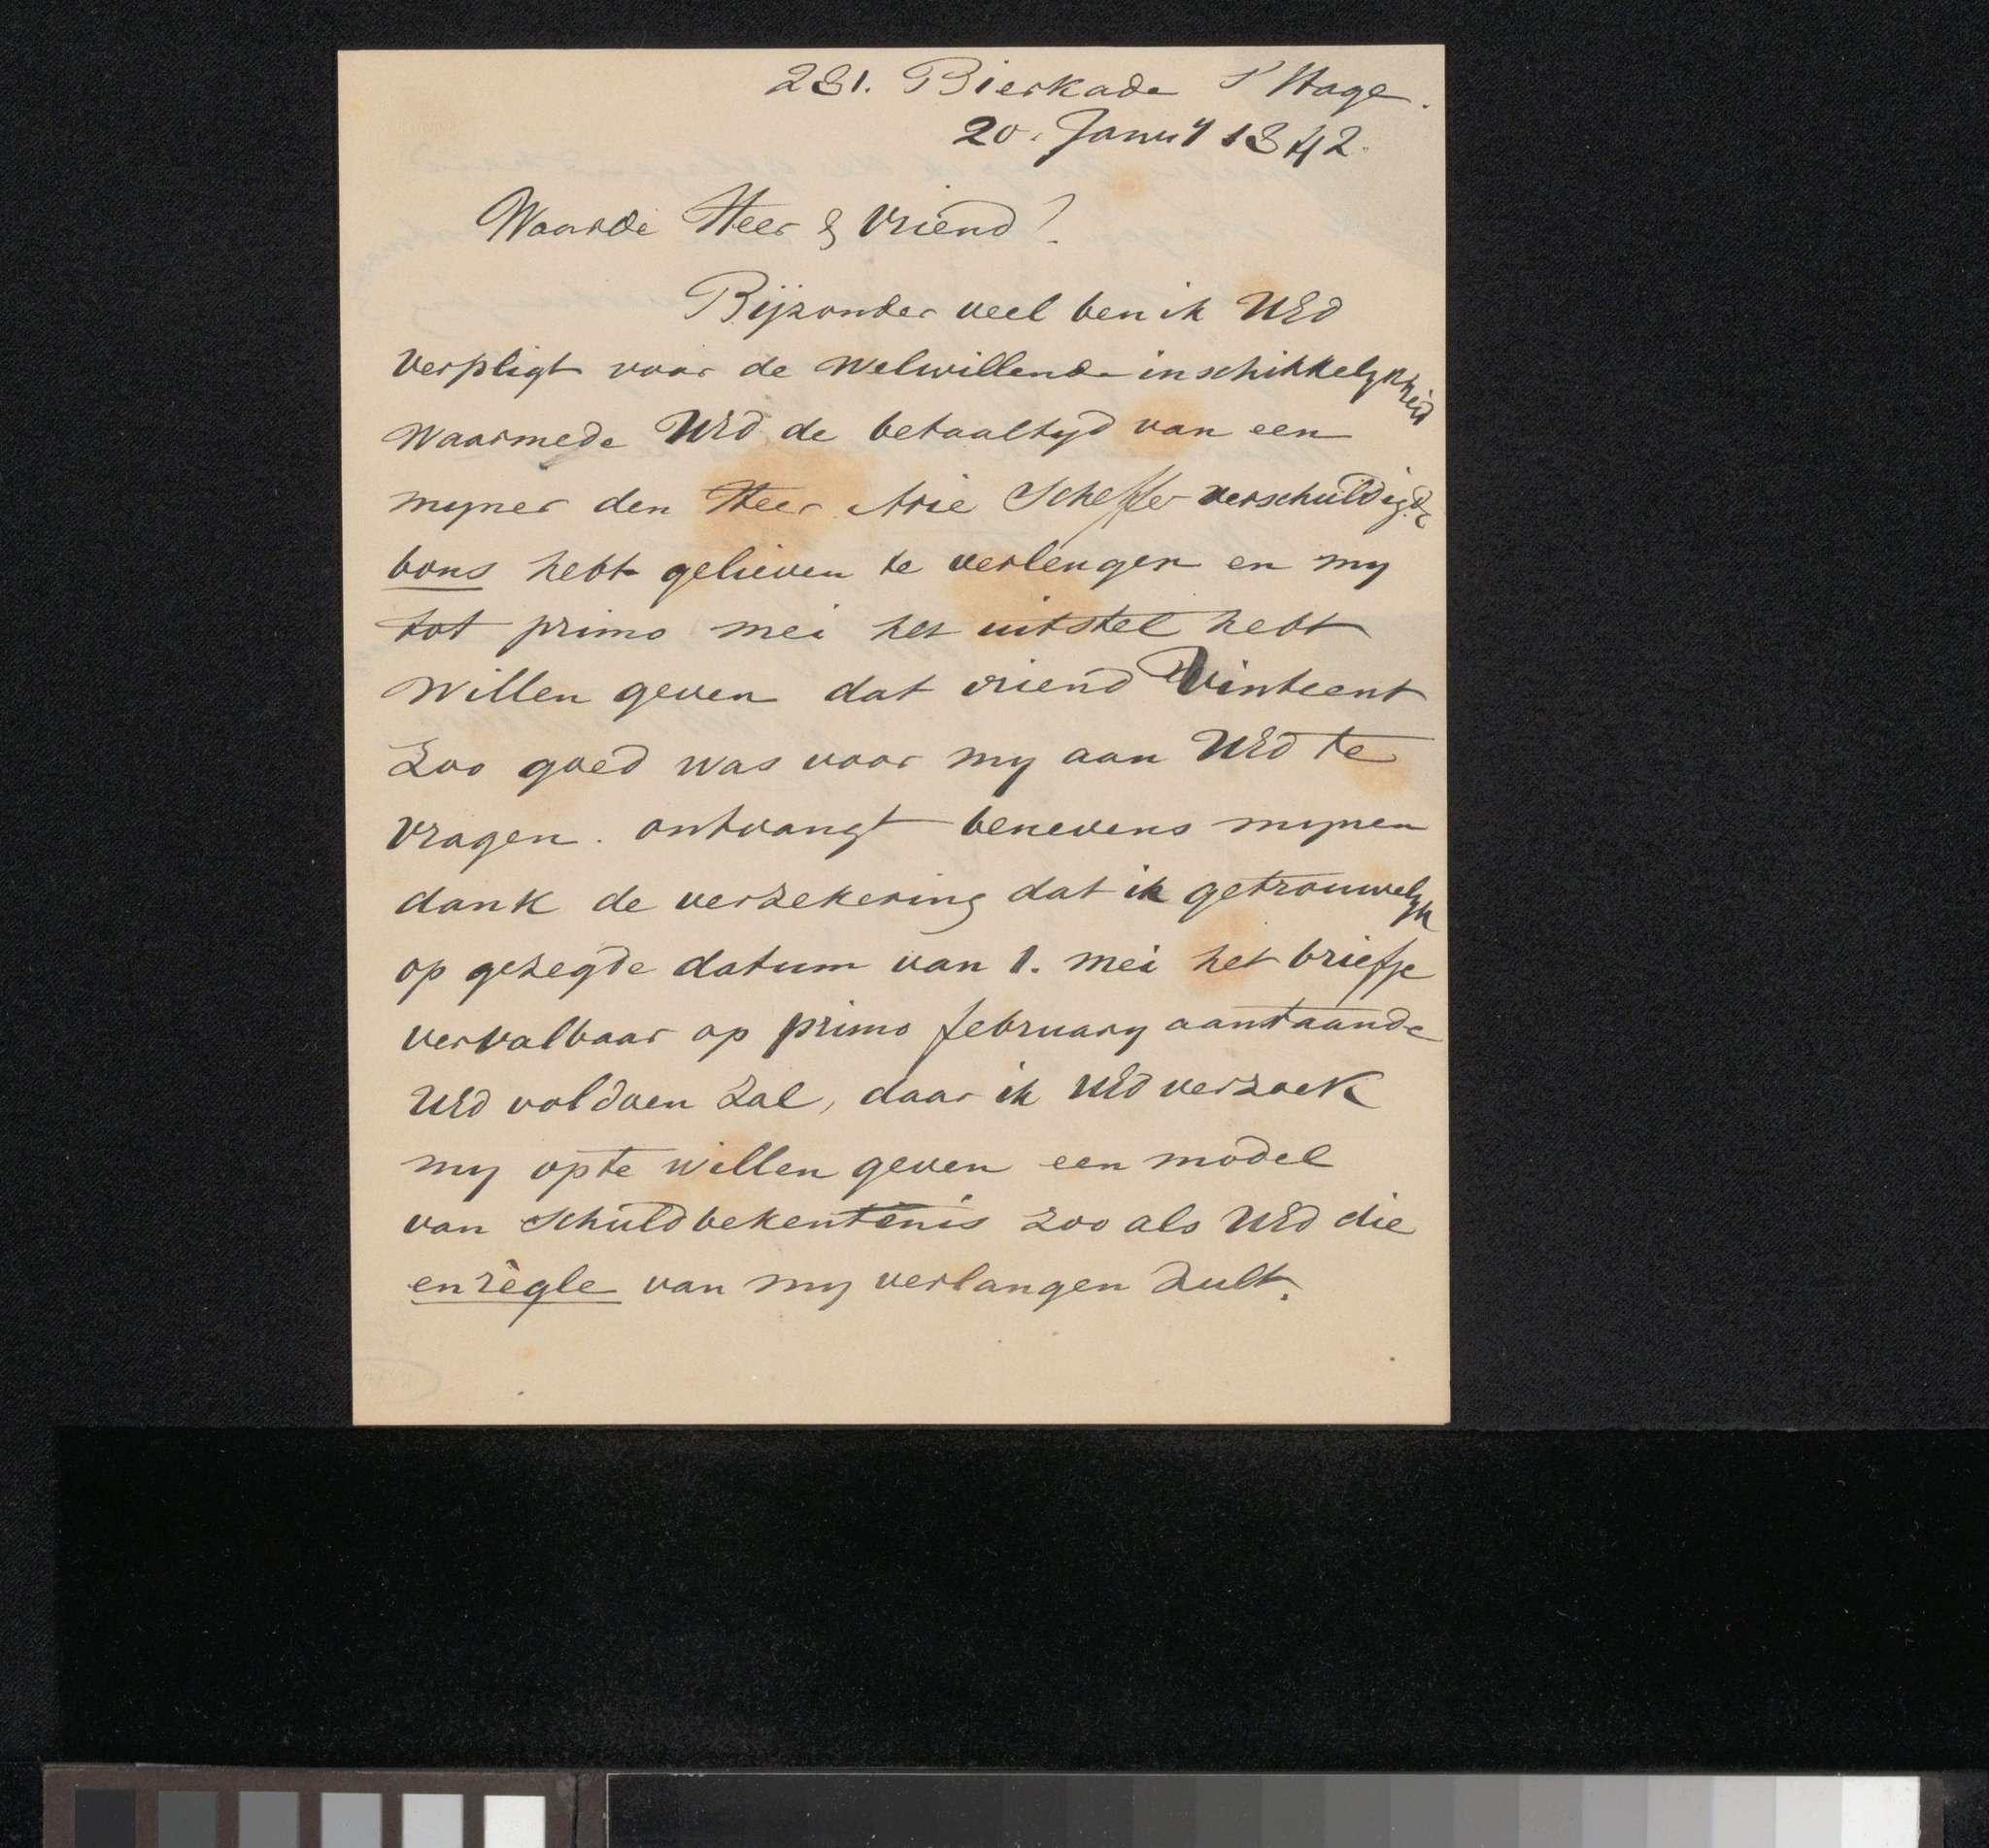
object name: letter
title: Brief aan Ary Johannes Lamme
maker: johannes de mare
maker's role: draughtsman, print maker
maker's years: 1806-1889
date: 1842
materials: ink, paper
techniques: pen, writing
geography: the hague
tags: dordrecht, painter, print maker, draughtsman, sculptor, ary scheffer, ary johannes lamme, the hague, lodewijk anthony vintcent, money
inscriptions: seal, collector's mark: Lugt 2228